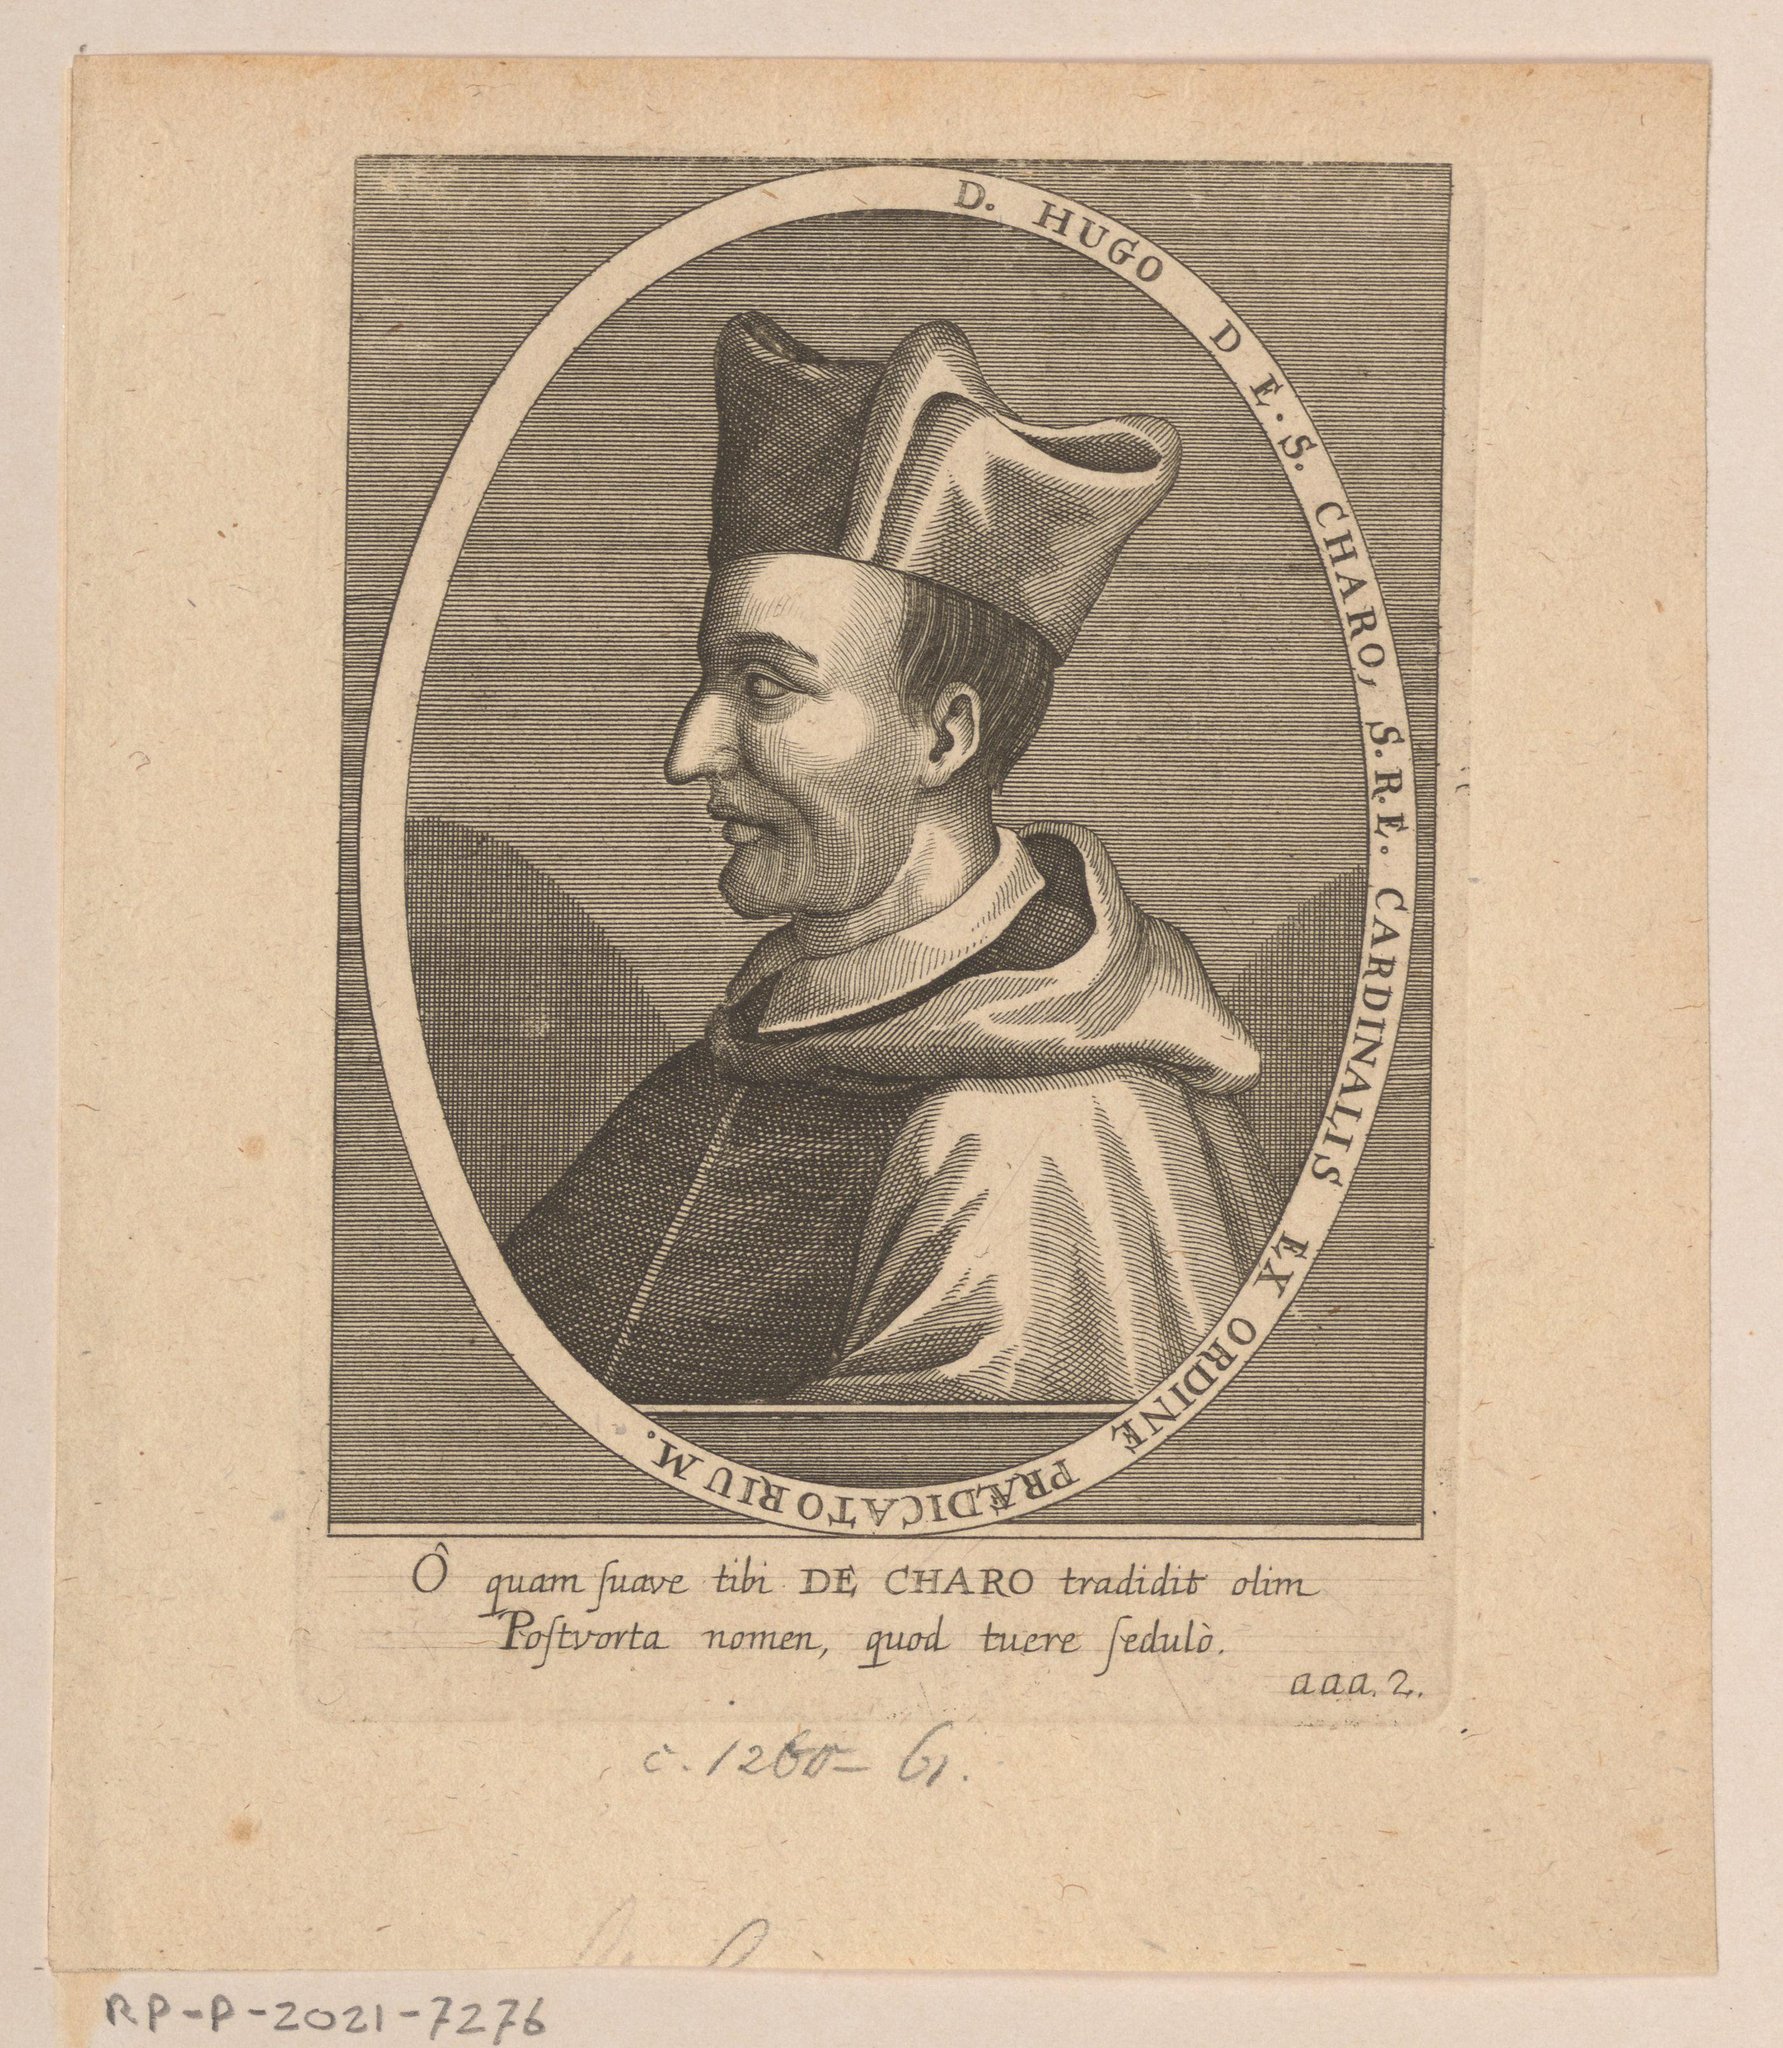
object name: print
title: Portret van Hugo van Saint-Cher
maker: Anonymous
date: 1652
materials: paper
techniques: engraving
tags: cardinal, historical persons, monastic orders, monastic life: dominicans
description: Prent waarschijnlijk uit: Bibliotheca chalcographica (...). Frankfurt am Main: Johannes Ammon, 1652, dl 8.